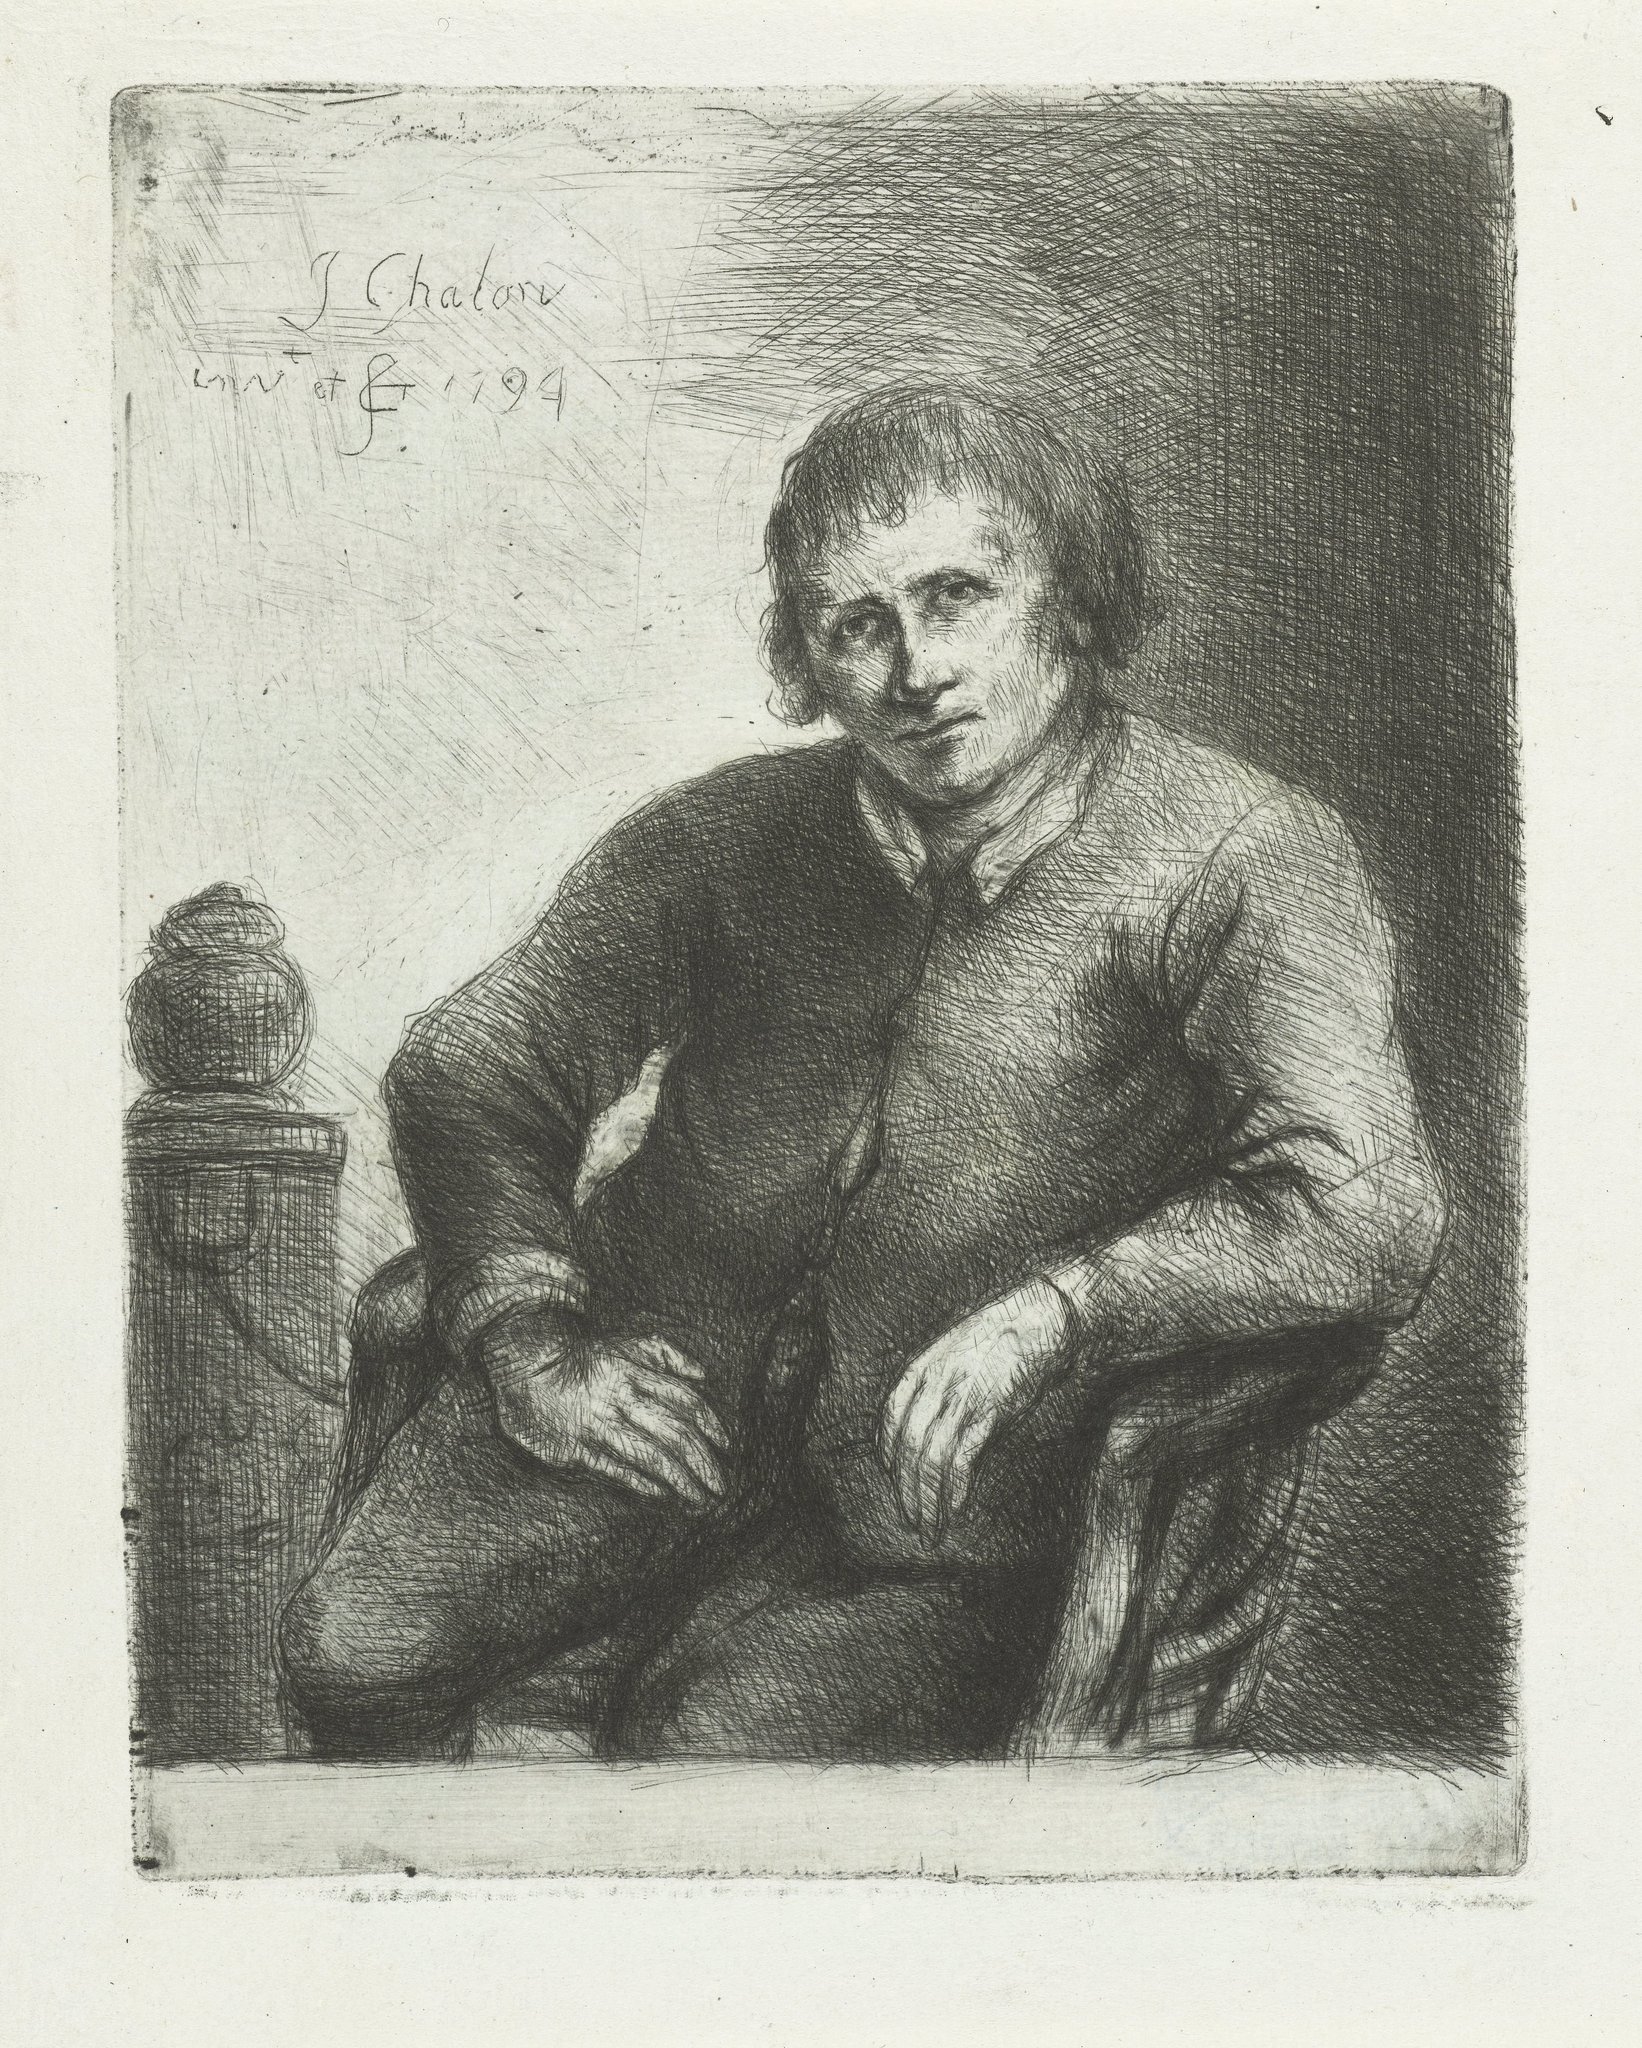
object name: print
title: Zittende man naast een pilaar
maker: jan chalon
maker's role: print maker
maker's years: 1738-1795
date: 1794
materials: paper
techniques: drypoint, etching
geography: northern netherlands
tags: half-column, pilaster ~ architecture, morphology of human expression (+ adult male (human being))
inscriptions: collector's mark: Lugt 924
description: Een volwassen man. Hij zit op een stoel naast een pilaar.